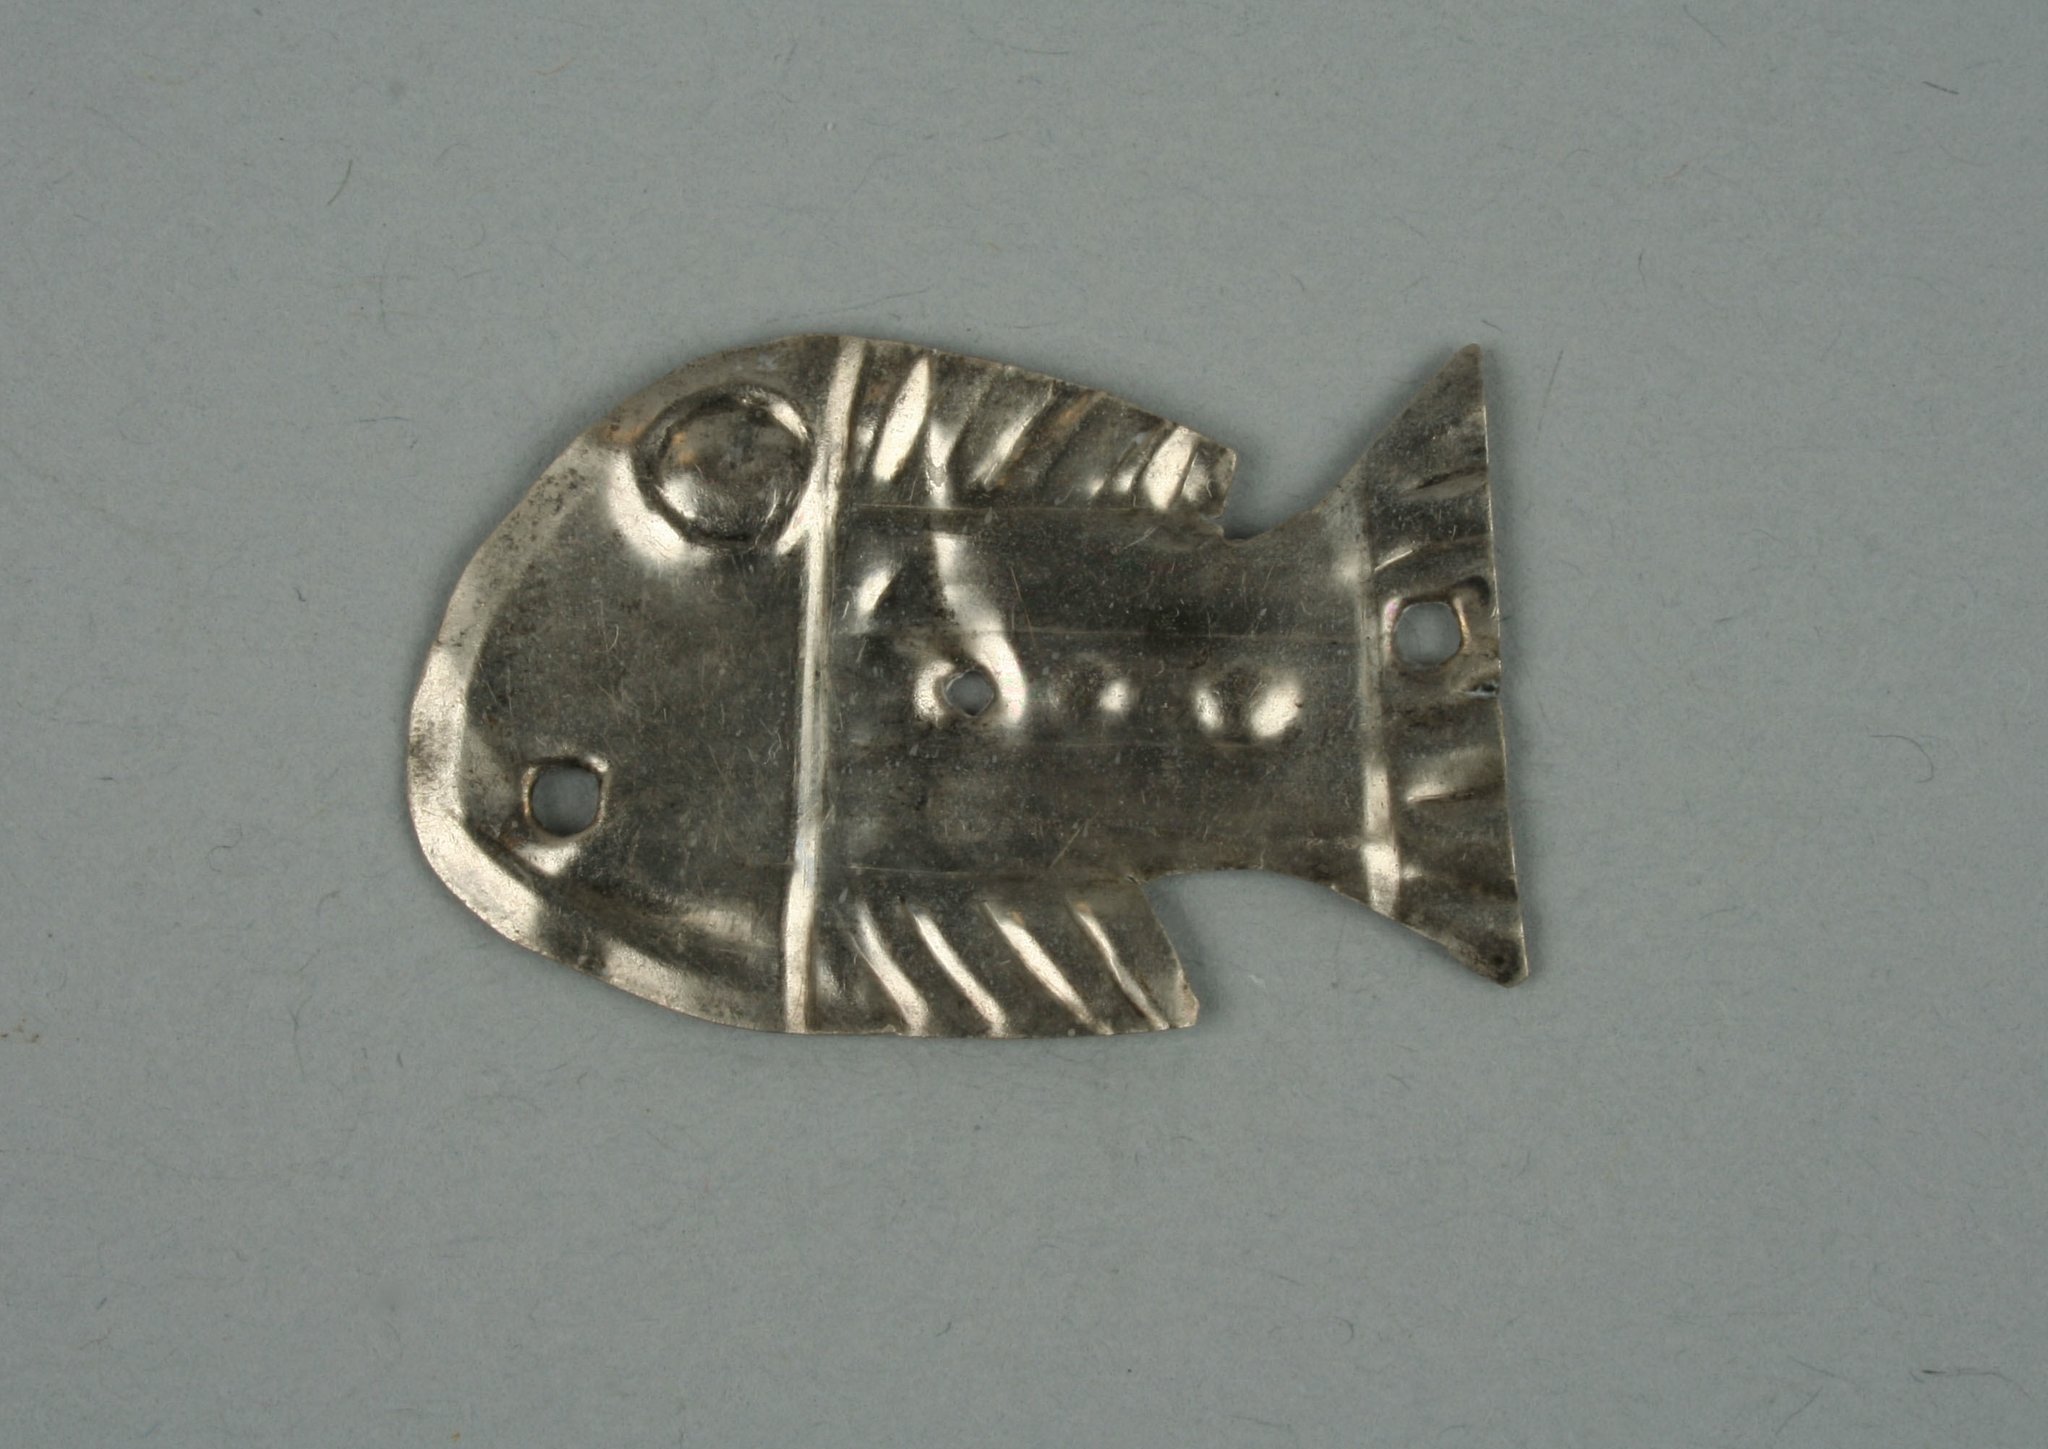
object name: ornament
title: Fish Ornament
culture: peruvian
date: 1001-1200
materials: silver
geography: peru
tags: fish